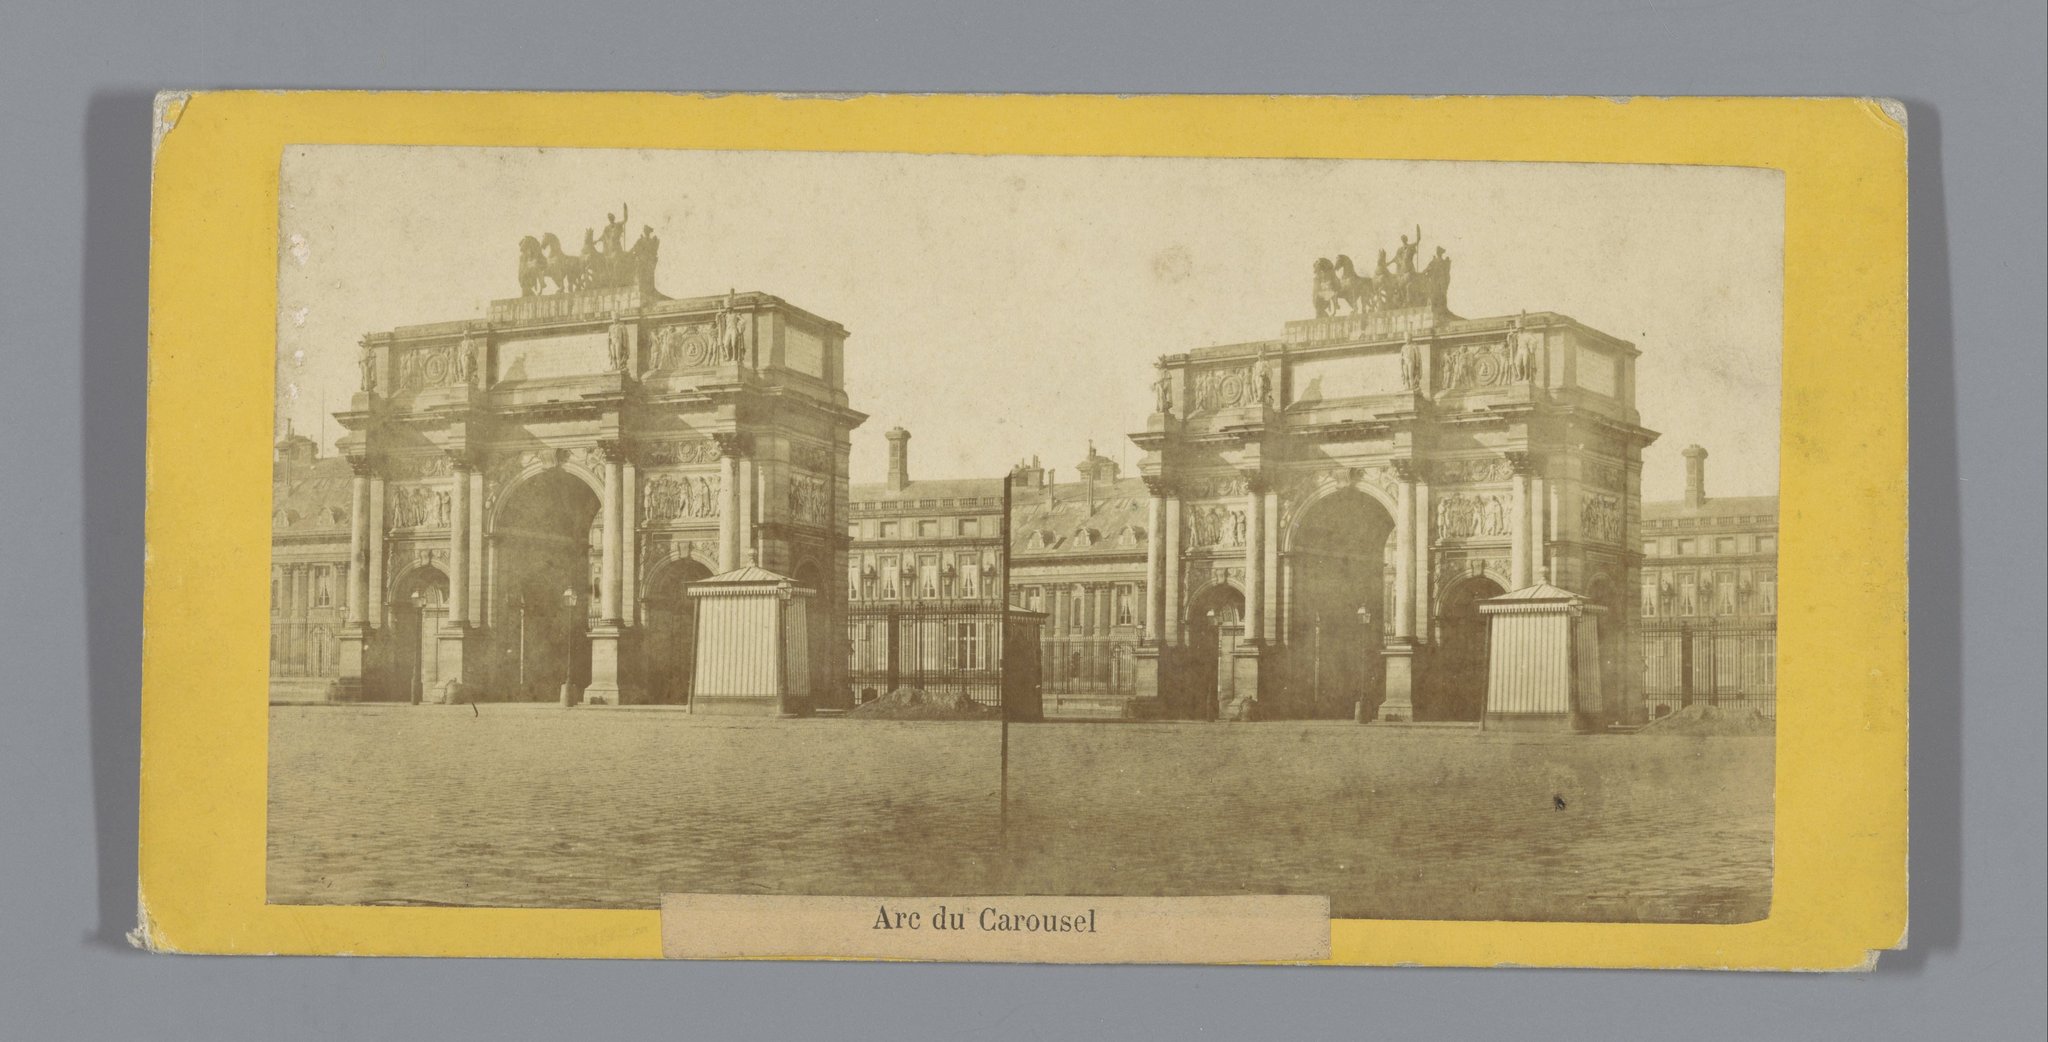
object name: stereograph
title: Arc de Triomphe du Carrousel te Parijs, met op de achtergrond het Palais des Tuileries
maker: Anonymous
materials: cardboard, photographic support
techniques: albumen print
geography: place du carrousel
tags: triumphal arch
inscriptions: number: ‘No 30.’